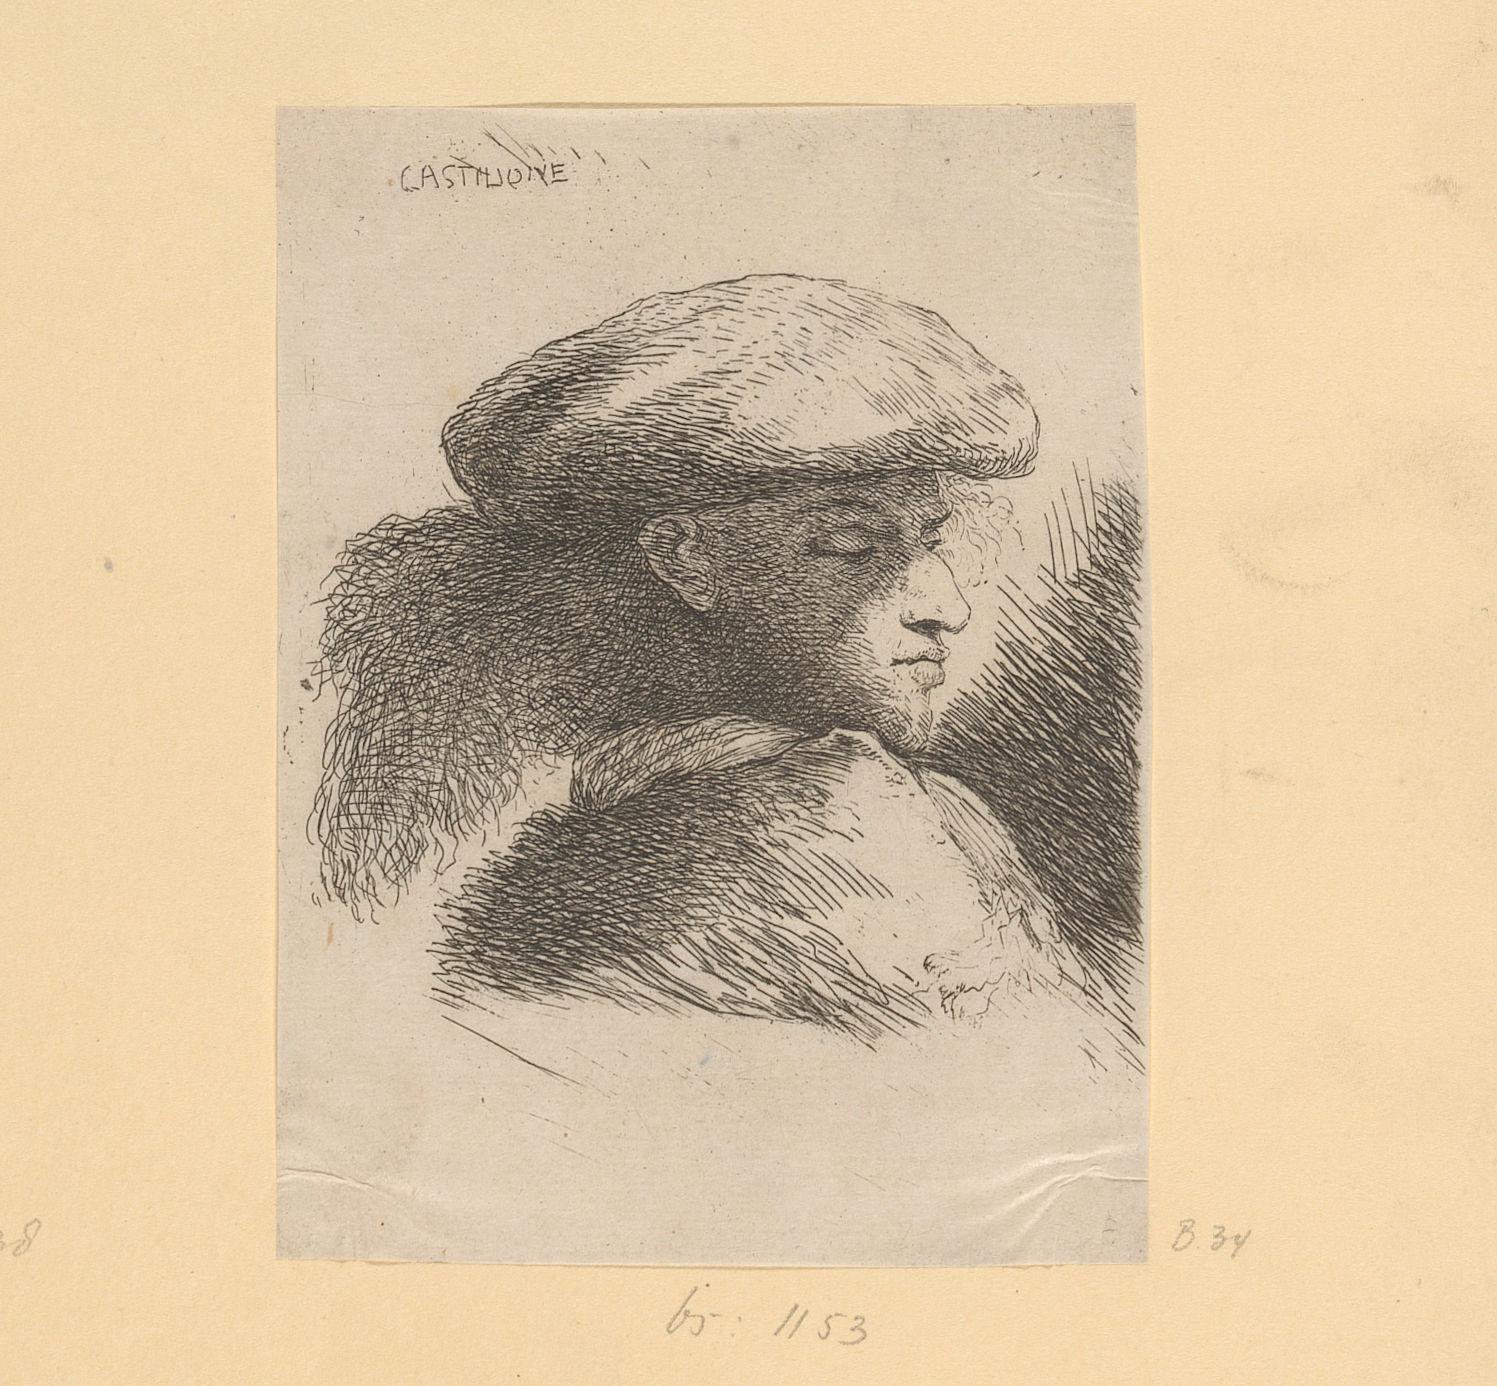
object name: album leaf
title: Kleine studie van hoofden met oosterse hoofddeksels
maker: giovanni benedetto castiglione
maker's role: draughtsman, print maker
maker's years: 1610-1665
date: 1645-1650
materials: paper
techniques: etching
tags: head (human), head-gear: cap (+ feathers used for clothes), head-gear: cap (+ men's clothes)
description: Prent is onderdeel van een serie van zestien prenten. Prent maakt mogelijk deel uit van een serie van 200 prenten. Deze serie is onder de titel 'A Collection of two hundred original etchings' voor het eerst uitgegeven door J.M. Greery in 1816.